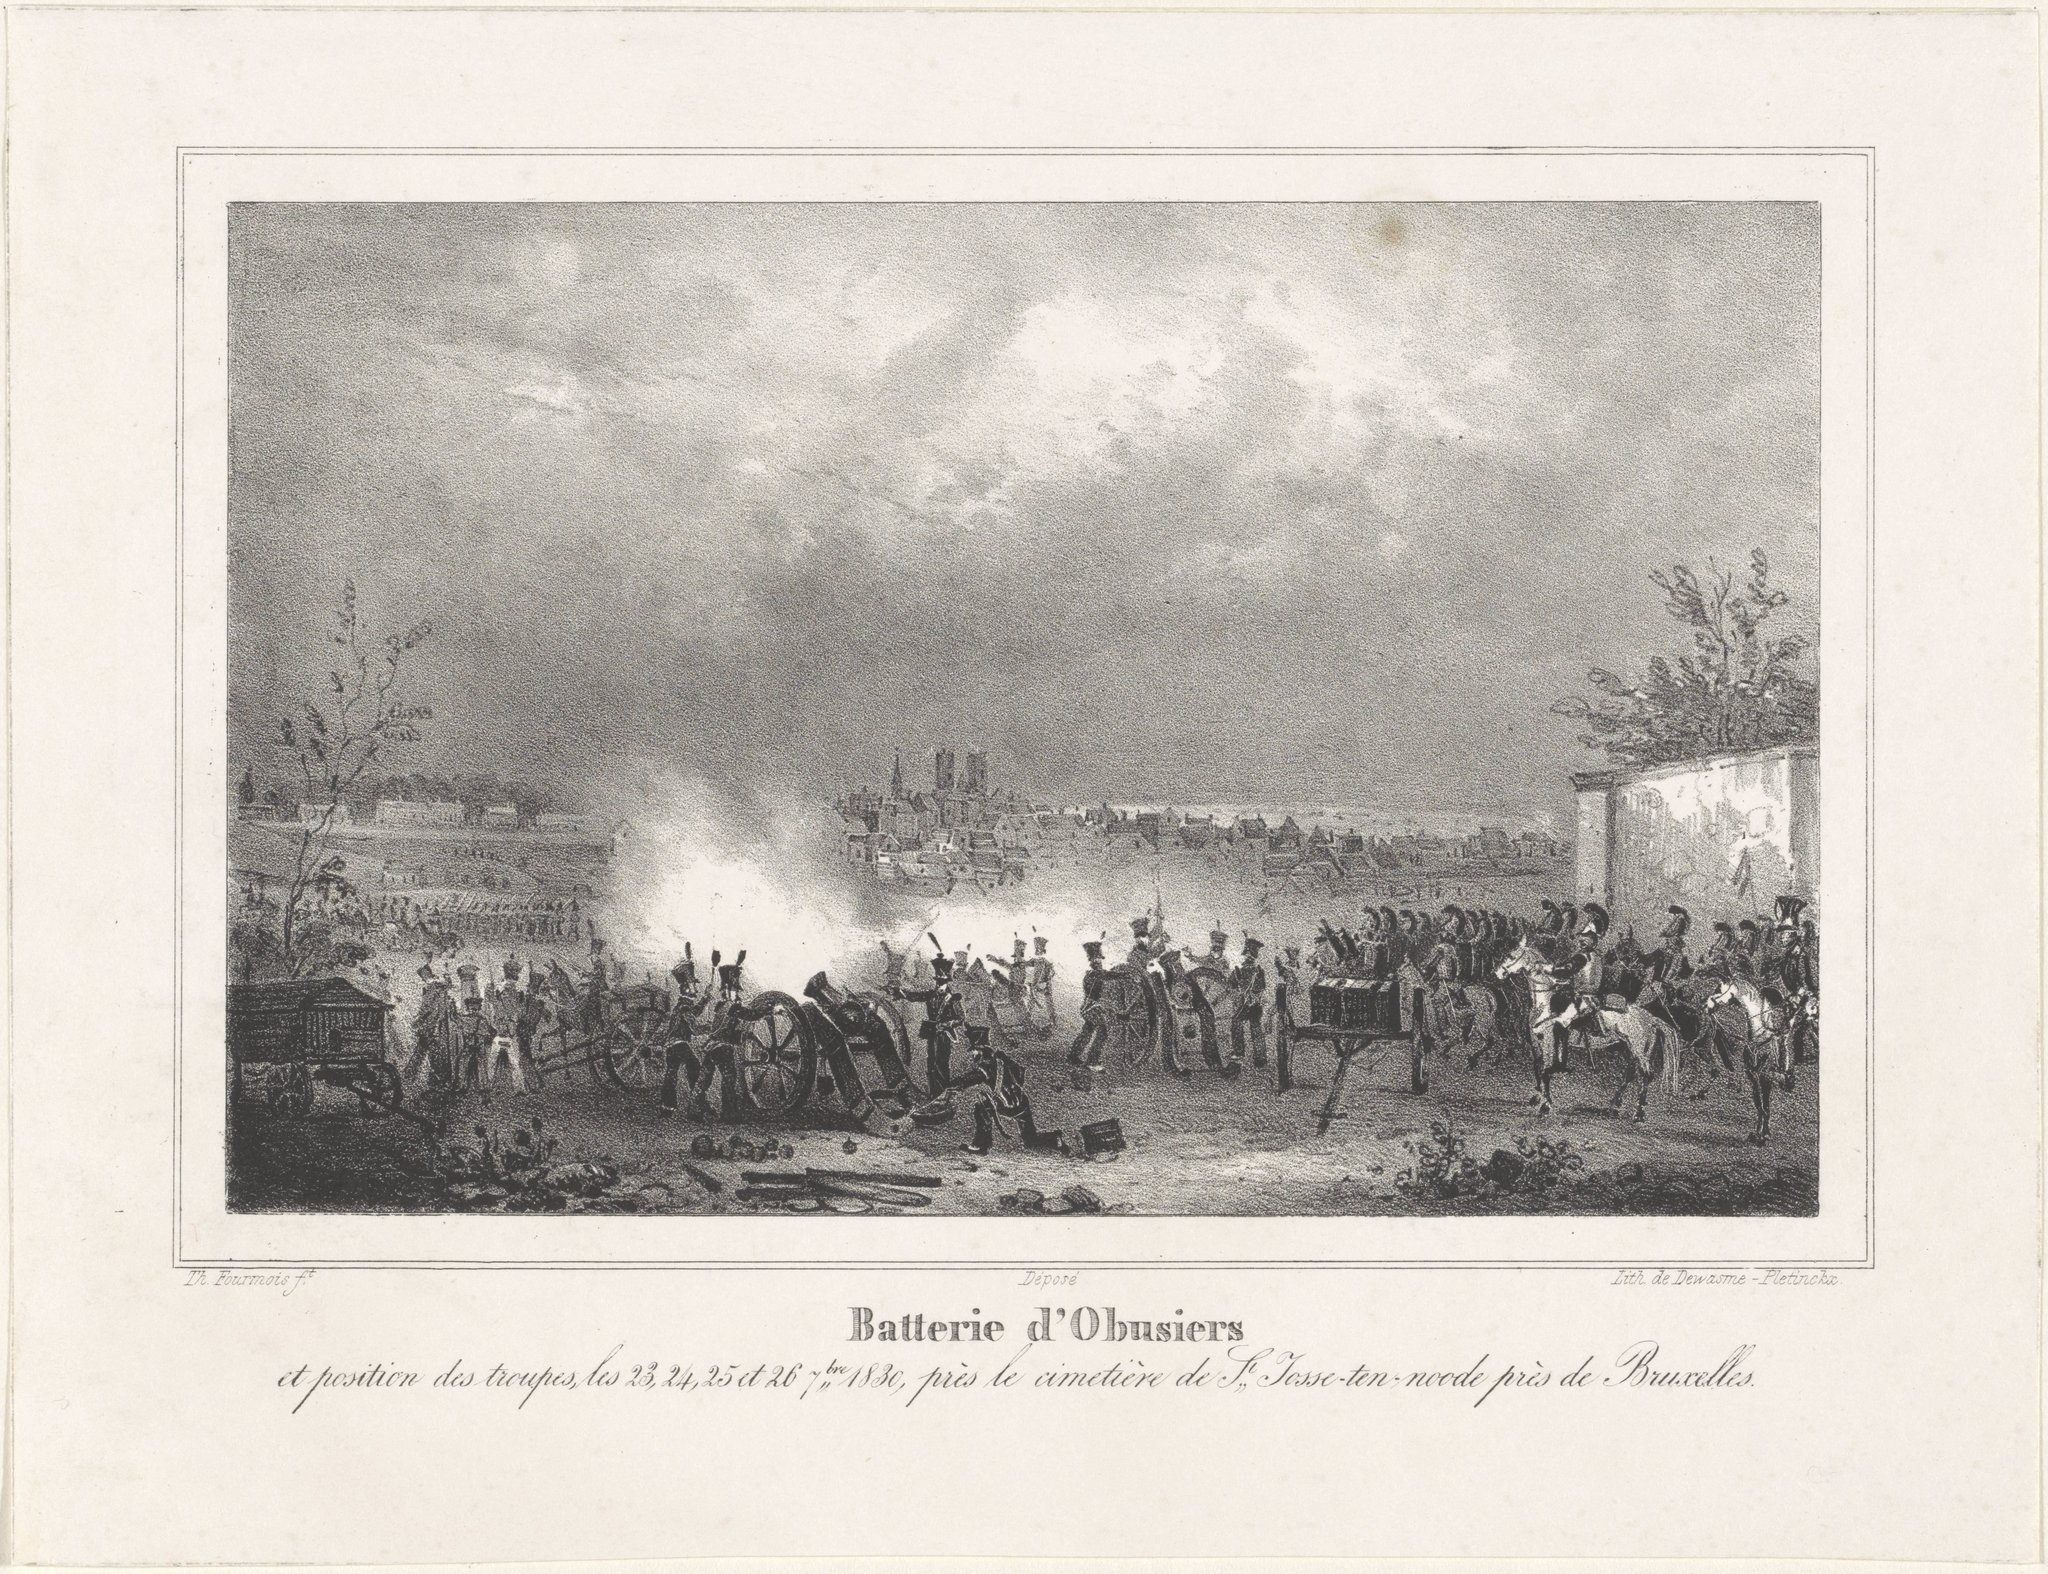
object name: print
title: Batterie d'Obusiers / et position des troupes, les 23,24,25 et 26 7bre 1830, près le cimetière de St. Josse-ten-noorde près de Bruxelles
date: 1830-1831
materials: paper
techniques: lithograph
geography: brussels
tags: battle (+ artillery), brussels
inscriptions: collector's mark: Lugt 2228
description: Nederlandse artilleriebatterij van houwitsers bij de begraafplaats van Sint-Joost-ten-Node buiten Brussel, 23-26 september. Onderdeel van een groep van prenten uit verschillende andere series verwant aan de platen in het recueil over de gebeurtenissen tijdens de Belgische Revolutie in Brussel, Antwerpen en andere steden in de periode 25 augustus 1830 tot 27 maart 1831.